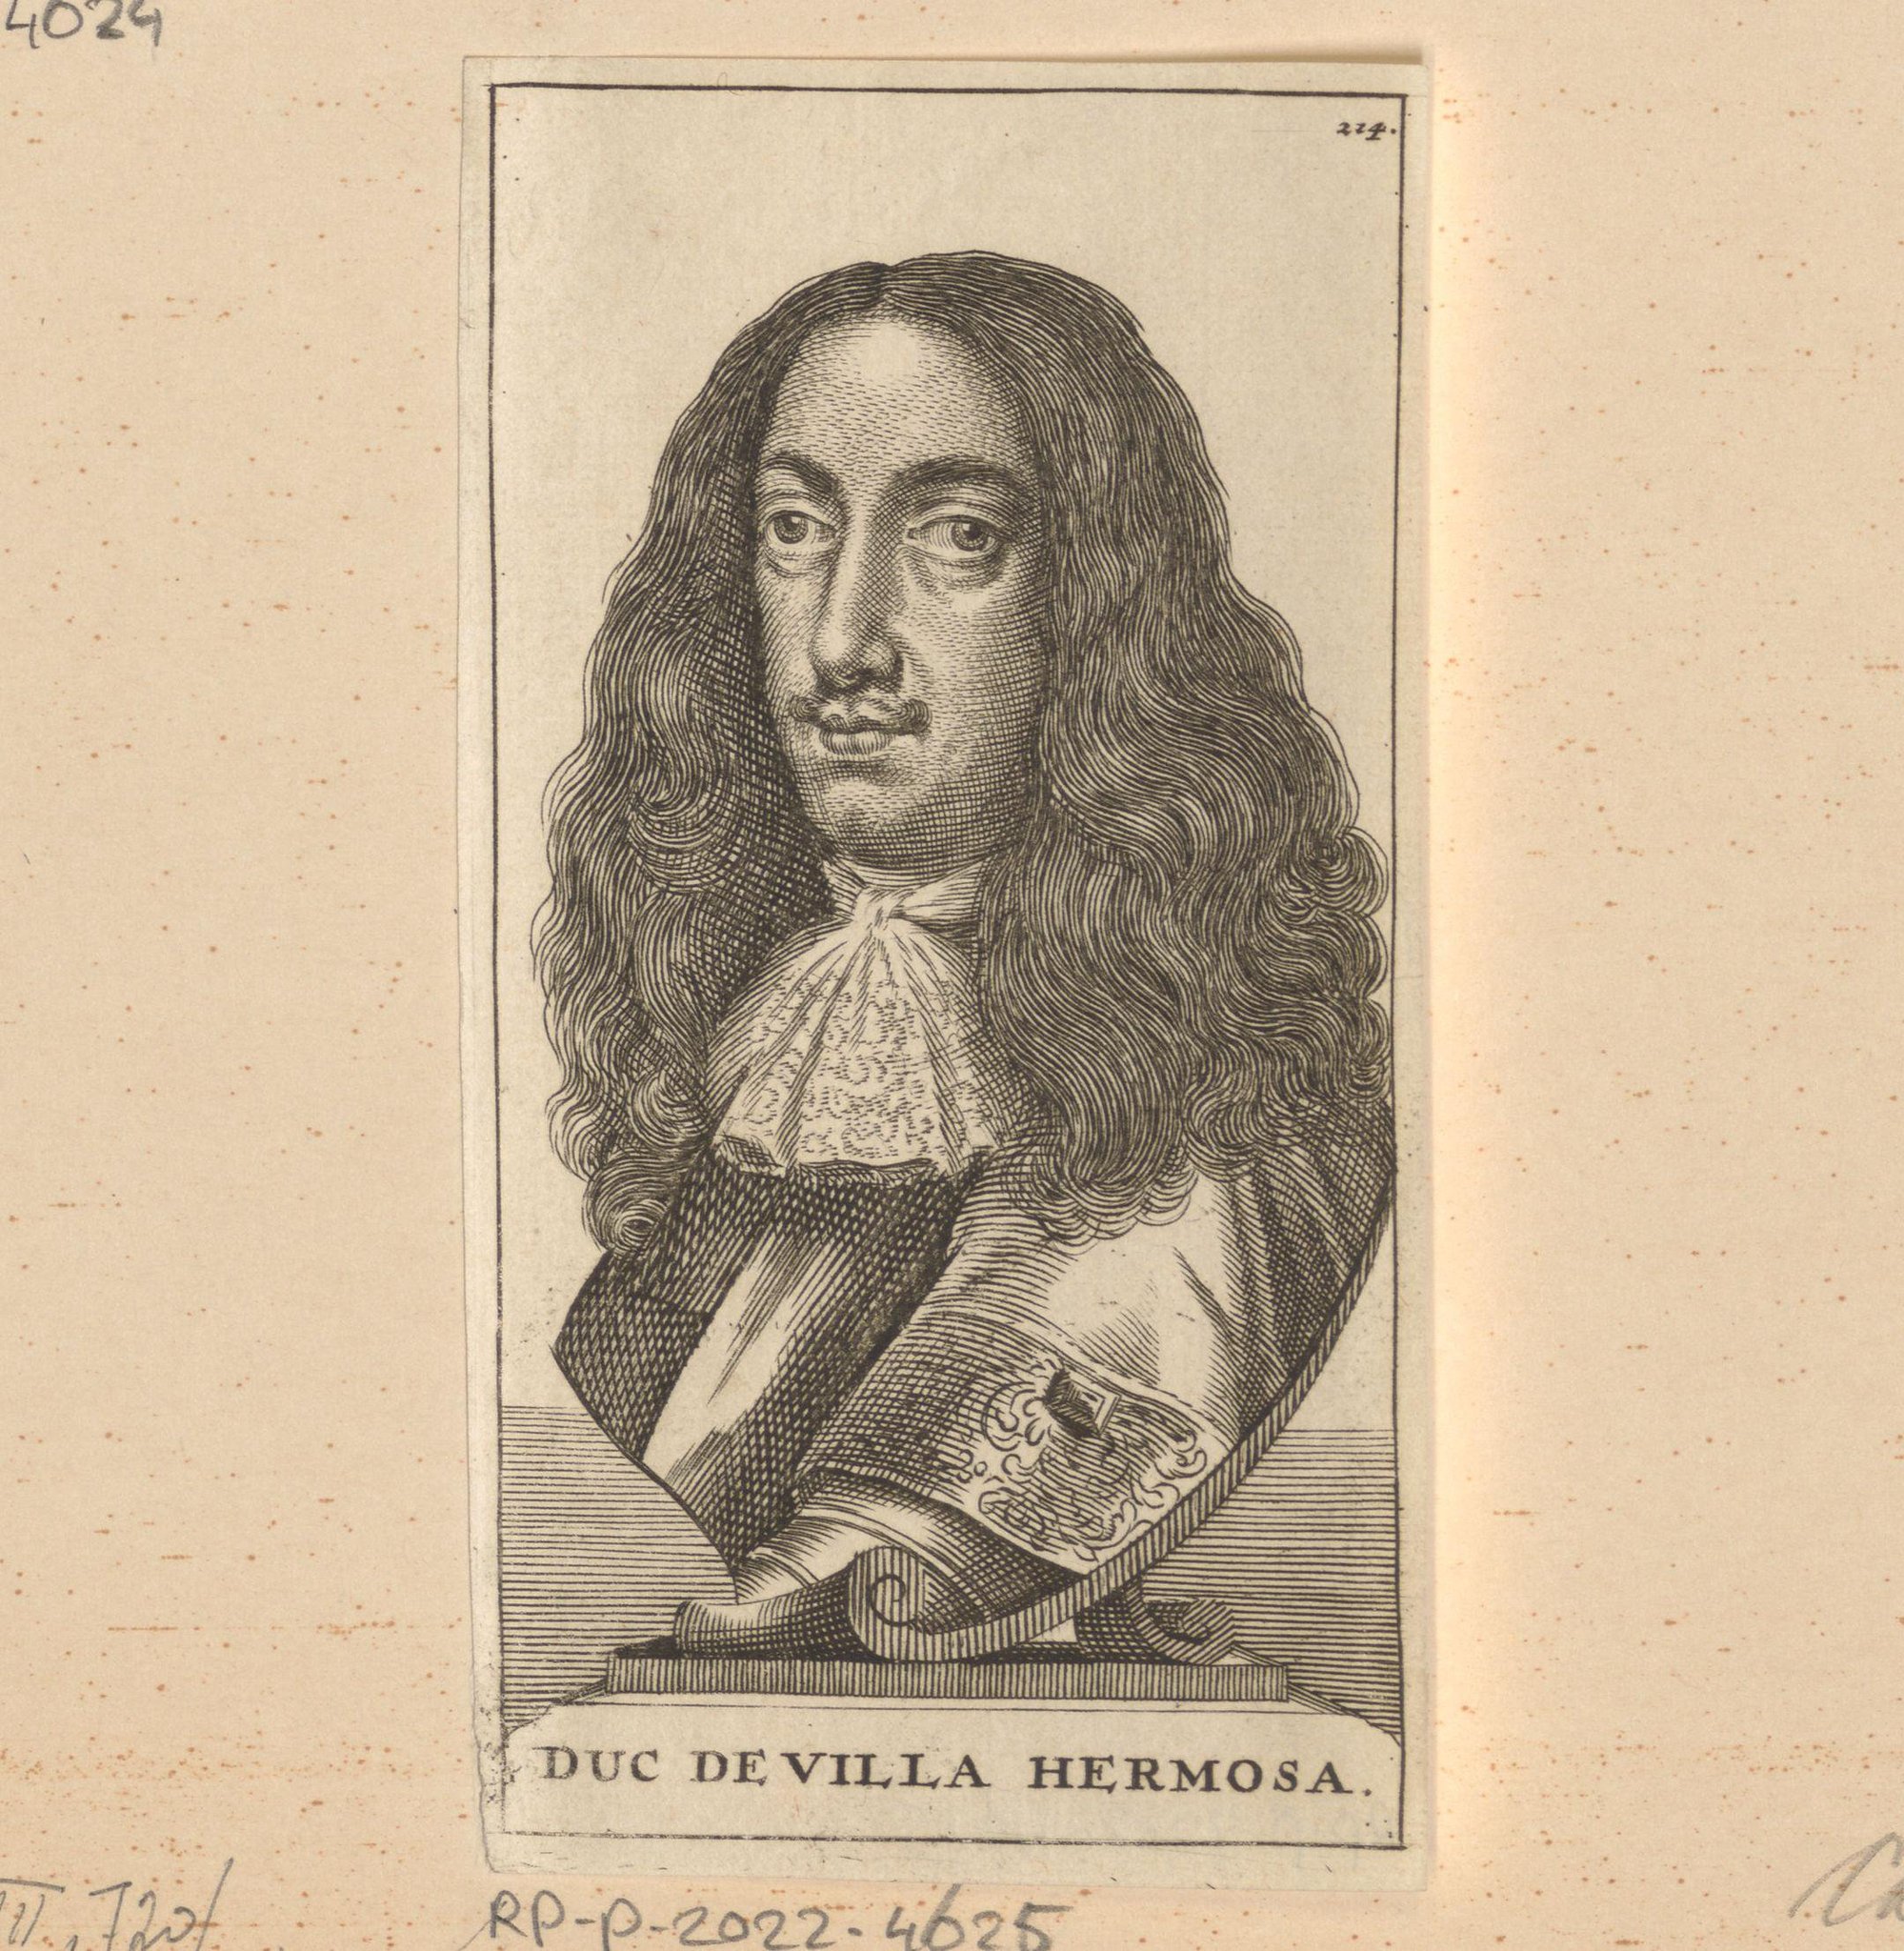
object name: print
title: Portret van Carlos de Gurrea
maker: Anonymous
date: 1678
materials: paper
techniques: engraving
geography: northern netherlands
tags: minister ~ government, commander-in-chief, general, marshal, historical persons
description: Prent waarschijnlijk uit: Le mercure Hollandois, contenant les choses les plus remarquables (...). Amsterdam: Henry en Theodoor Boom, 1678, p. 214.